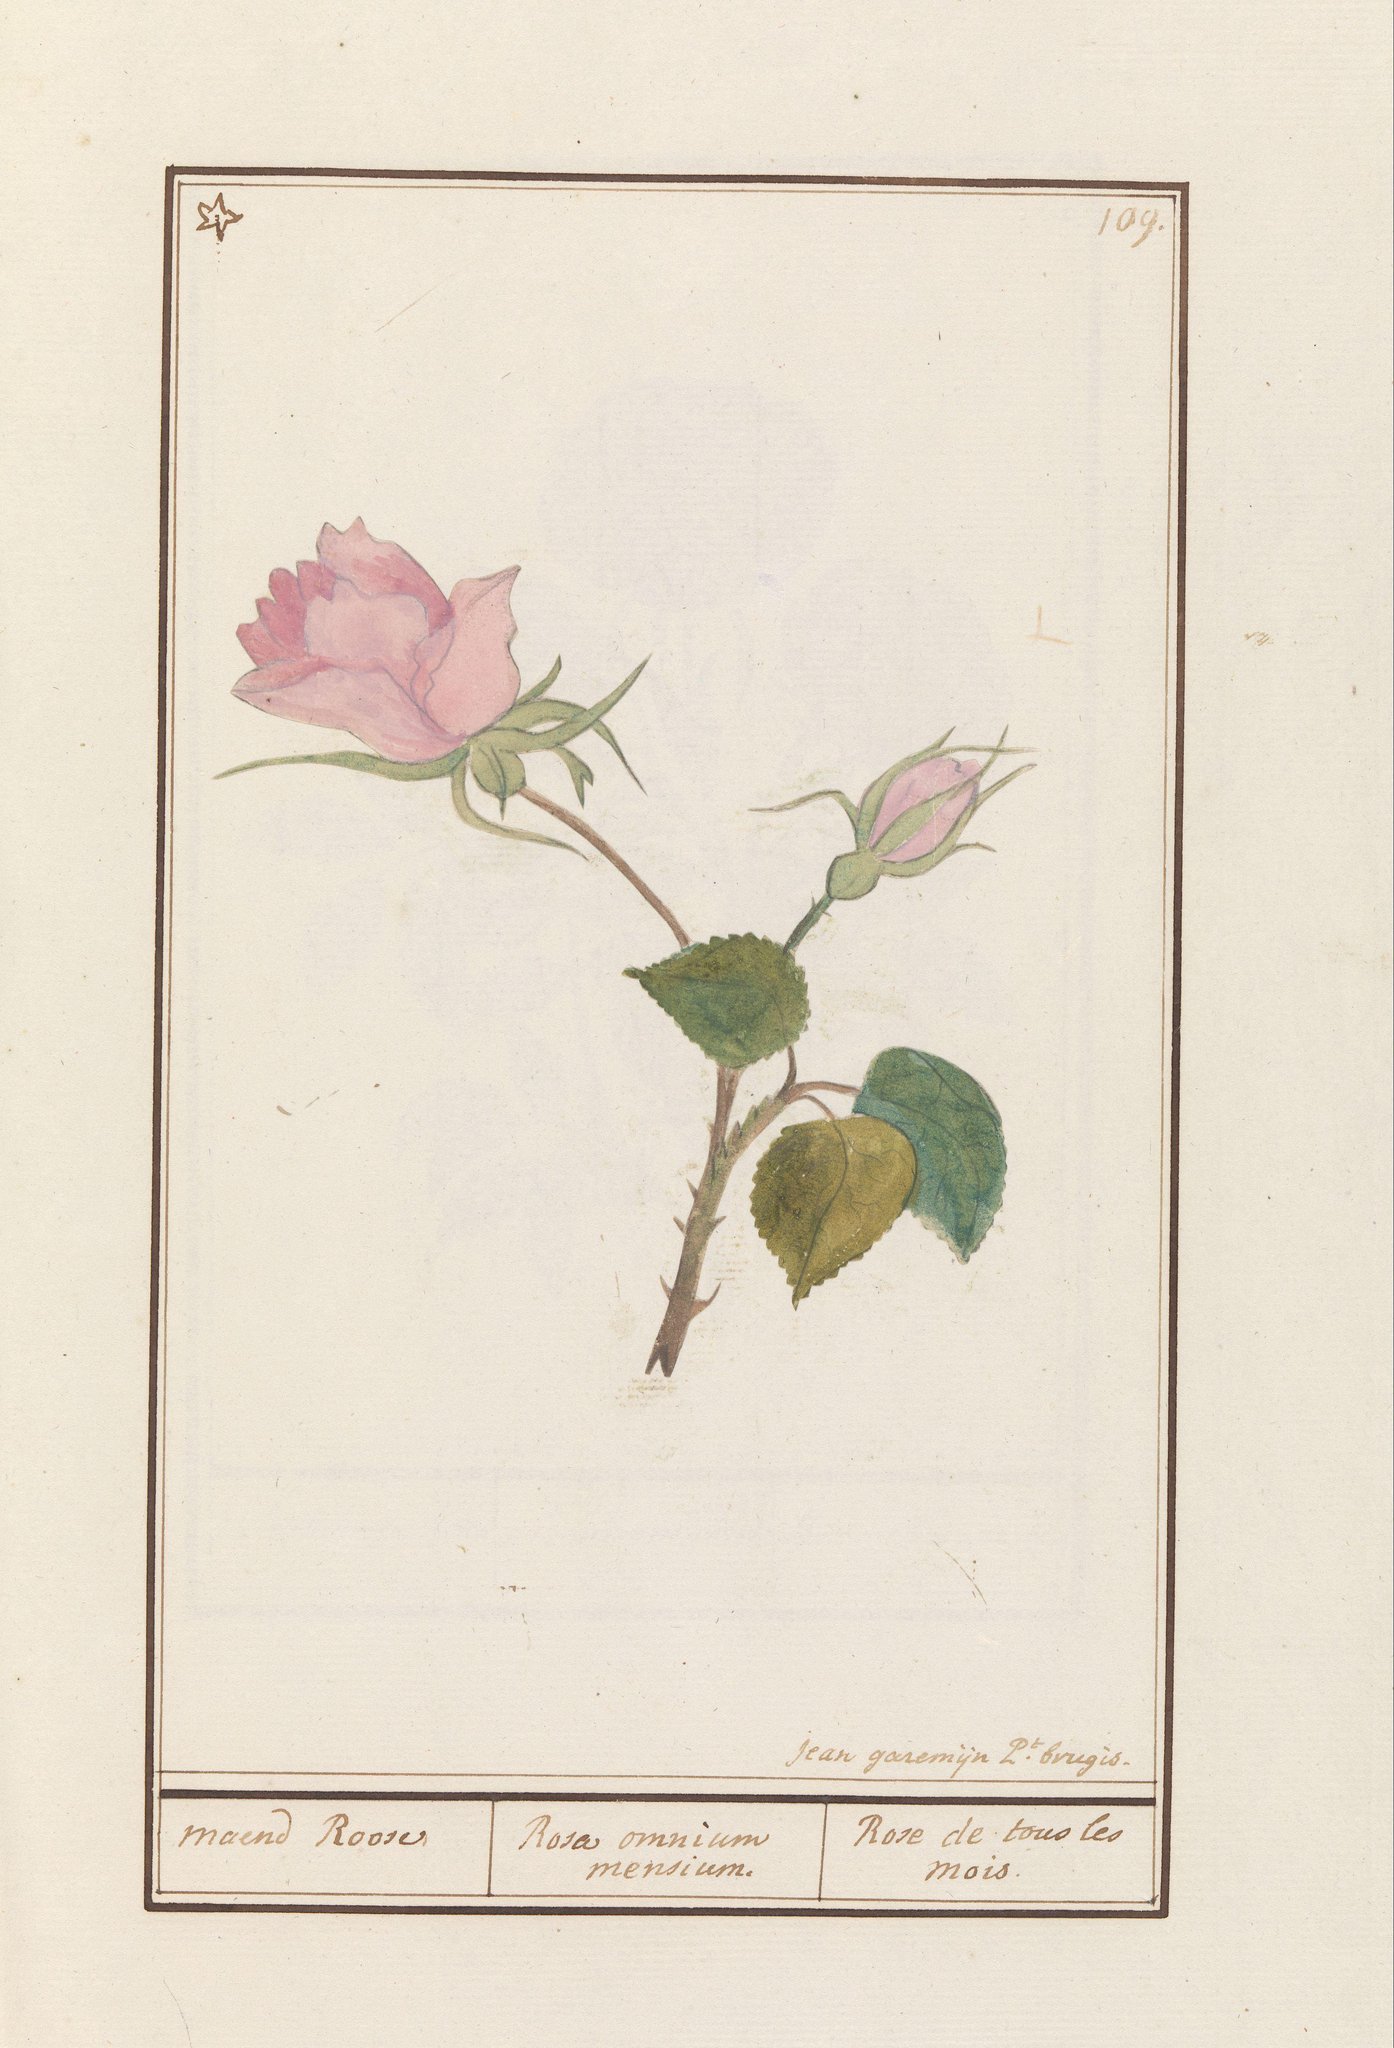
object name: drawing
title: maend Roose / Rosa omnium mensium / Rose de tous les mois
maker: jan anton garemyn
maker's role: draughtsman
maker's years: 1712-1799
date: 1790-1799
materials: paint, paper, watercolor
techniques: brush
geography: bruges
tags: flowers: rose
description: Roos. Rechtsboven genummerd: 109. Linksboven gemerkt met een sterretje. Onderdeel van het tweede album met tekeningen van bloemen en planten. Negende van twaalf albums met tekeningen van dieren, vogels en planten bekend rond 1600, gemaakt in opdracht van keizer Rudolf II. Met toelichting in Nederlands, Latijn en Frans.